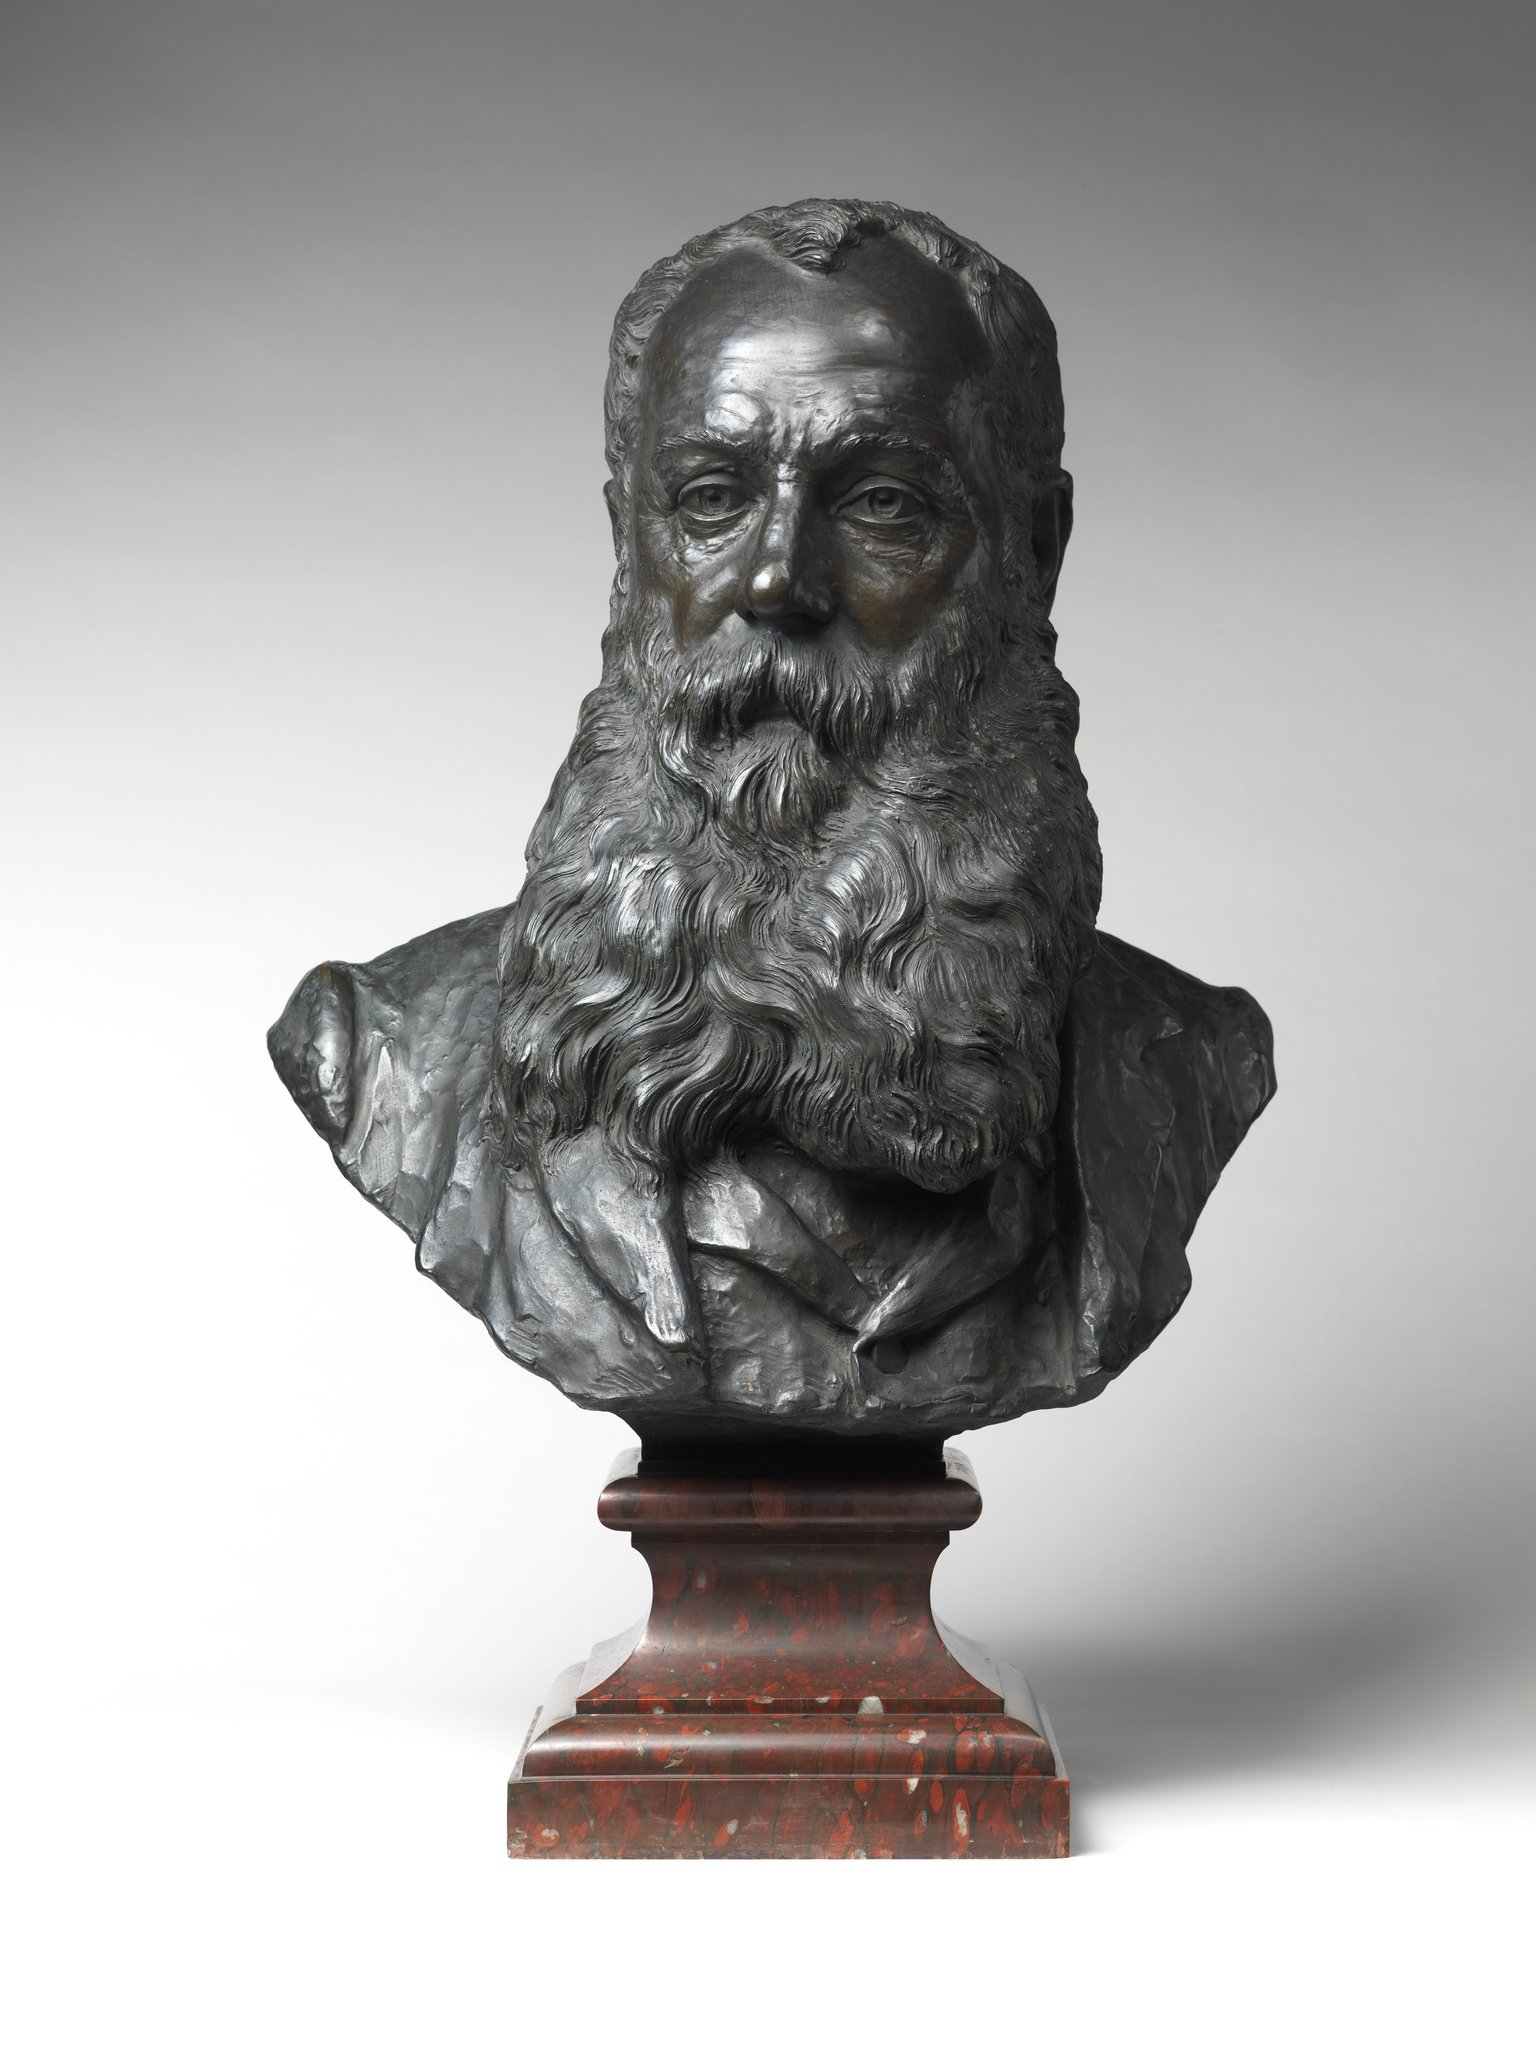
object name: bust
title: George A. Lucas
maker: augustin jean moreau-vauthier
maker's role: artist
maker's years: 1831-1893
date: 1890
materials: bronze, marble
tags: men,portraits